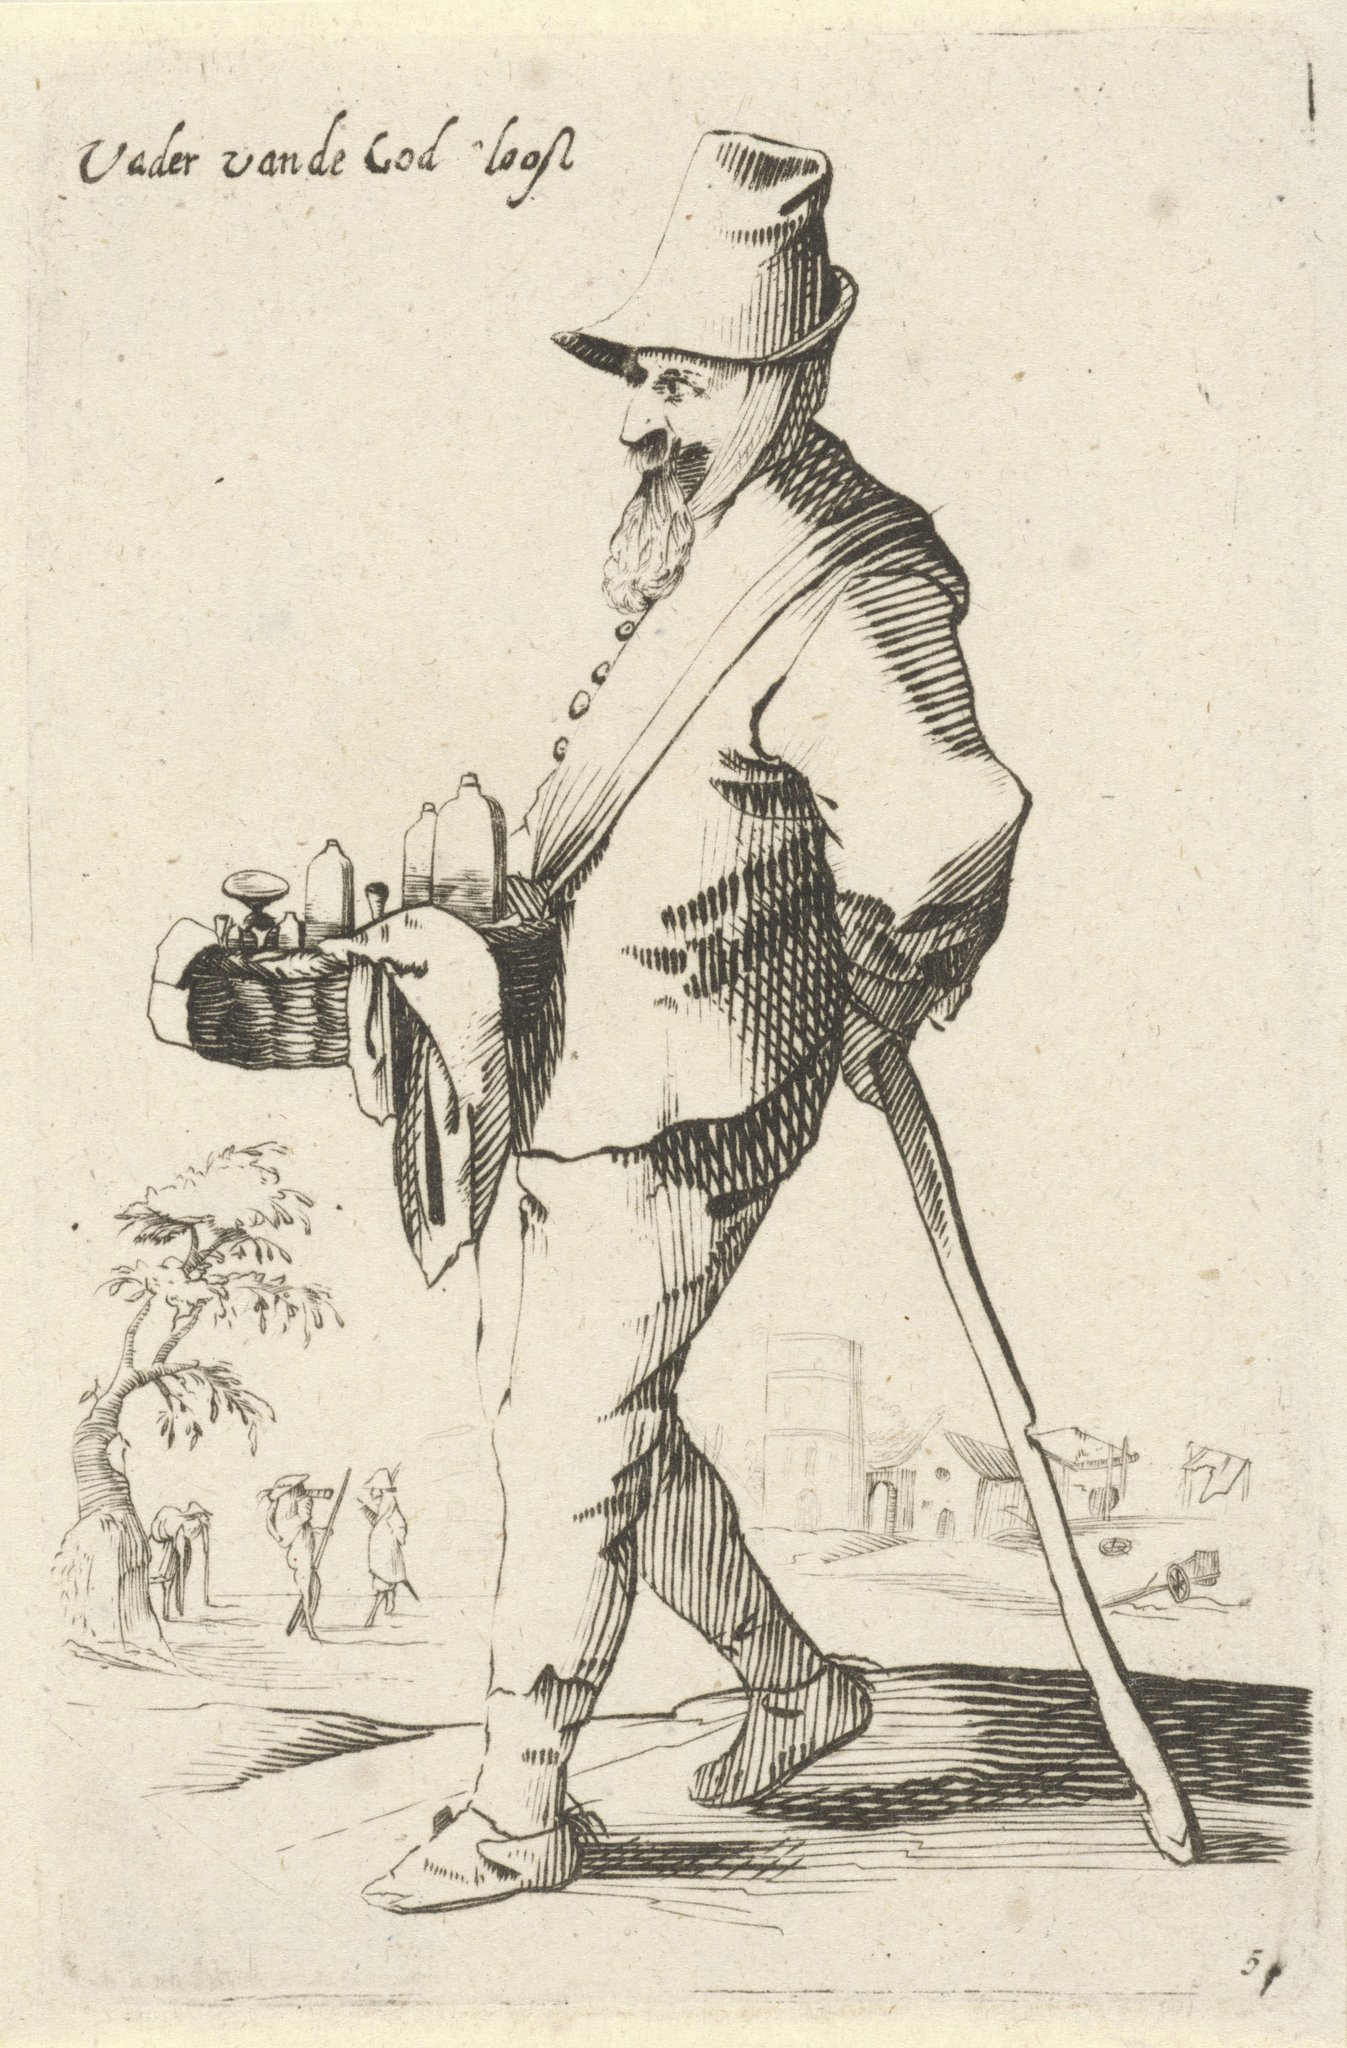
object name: print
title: Marskramer leunend op stok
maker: Anonymous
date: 1630-1715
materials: paper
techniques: engraving, etching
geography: amsterdam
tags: walking-stick, staff, wandering or travelling merchant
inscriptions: collector's mark: Lugt 240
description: Spiegelbeeldige kopie naar prent uit de twaalfdelige serie "T'Leven Der Boeren" van Salomon Savery naar Pieter Jansz. Quast.